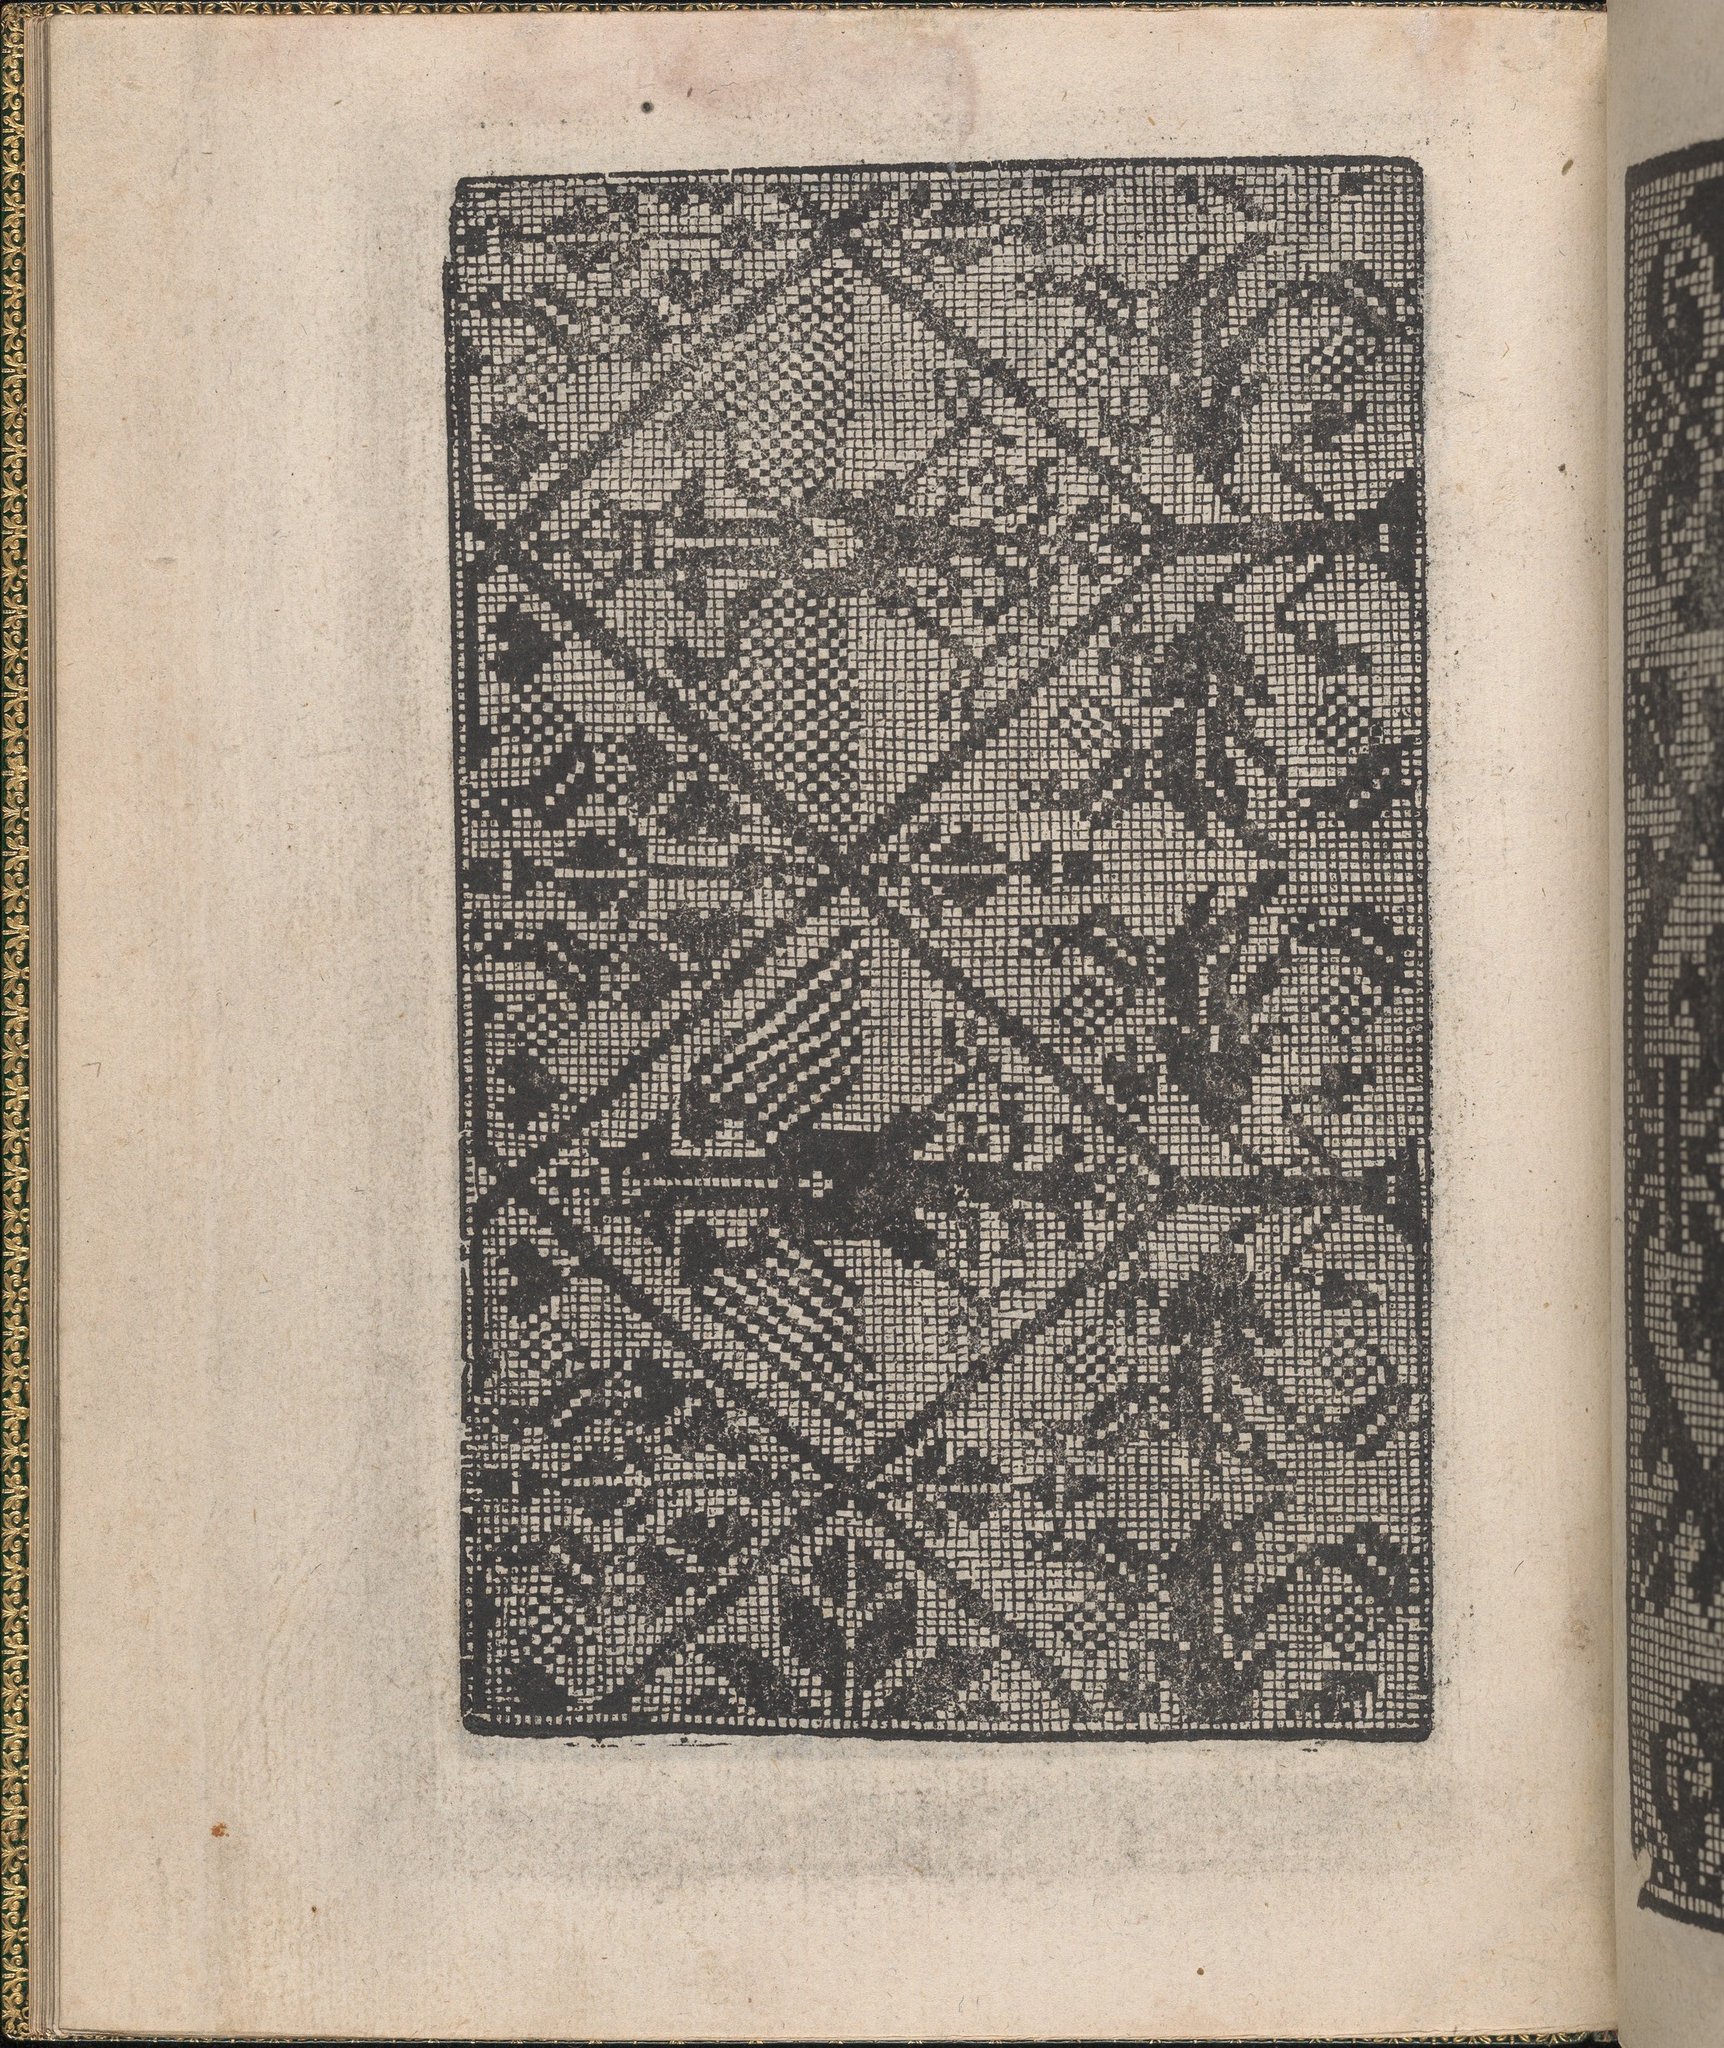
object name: book print ornament architecture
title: Ornamento delle belle & virtuose donne, page 18 (verso)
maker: matteo pagano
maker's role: publisher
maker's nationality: italian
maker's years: 1515-1588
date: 1554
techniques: woodcut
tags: birds,ornament